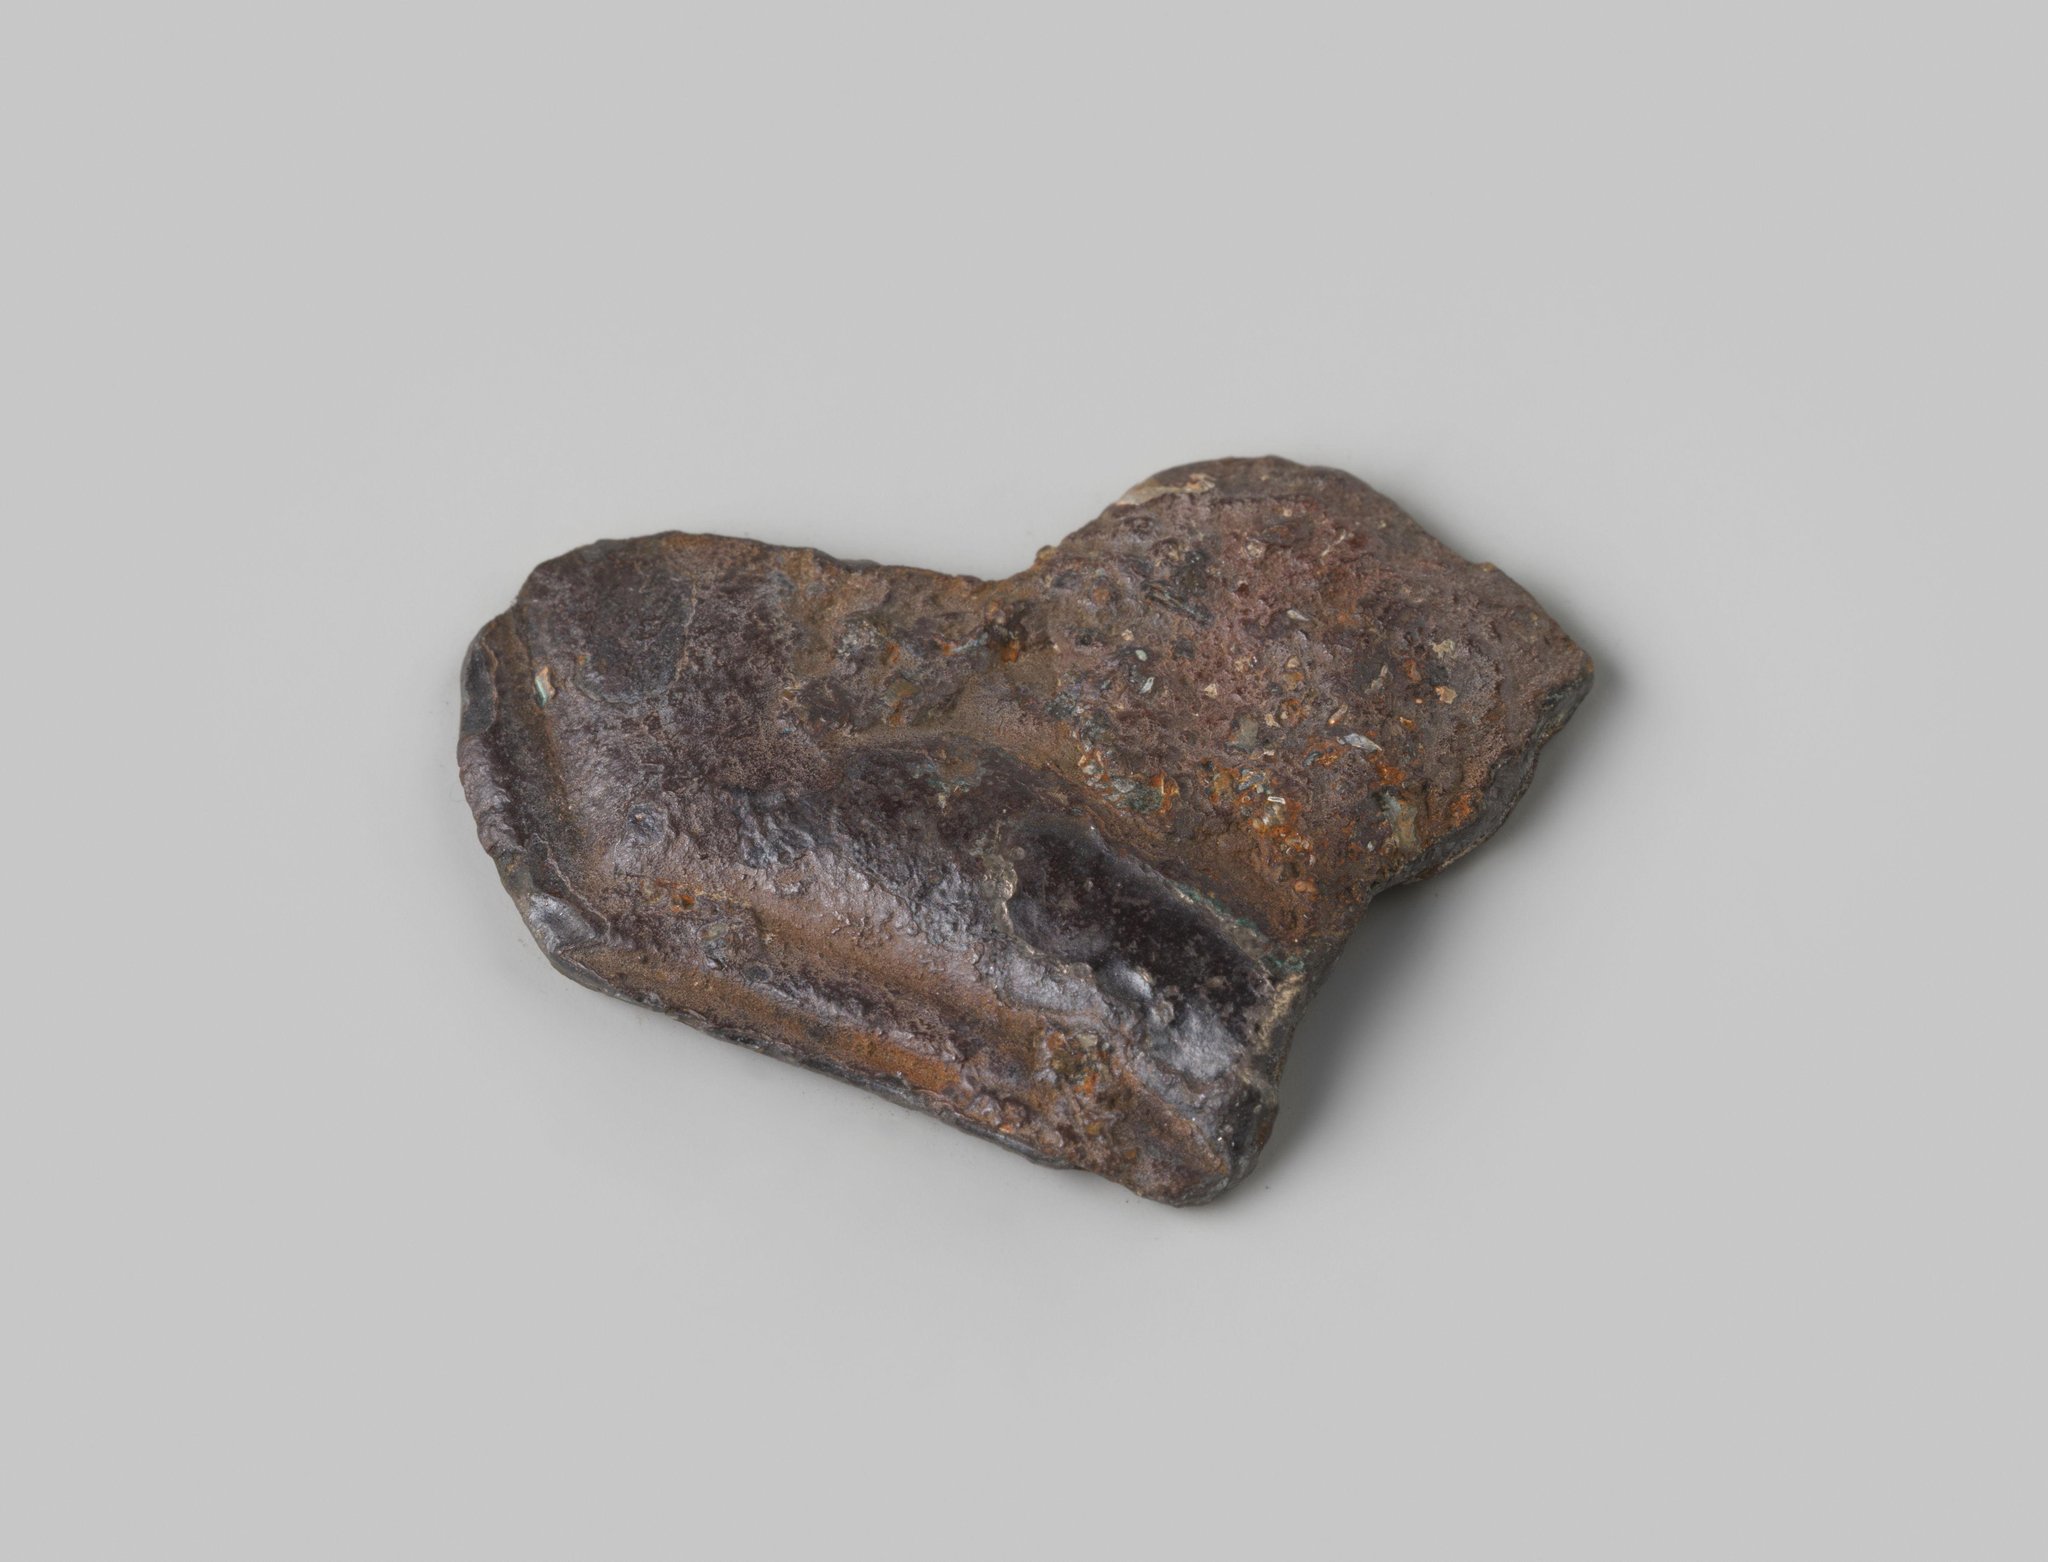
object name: candlestick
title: Fragment voet van een kandelaar uit het wrak van de Oost-Indiëvaarder Hollandia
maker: Anonymous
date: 1700-1743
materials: silver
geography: netherlands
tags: verenigde oostindische compagnie, hollandia (schip), annet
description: Candlestick, foot; fragm of rim, with angular pointed corner, faceted.